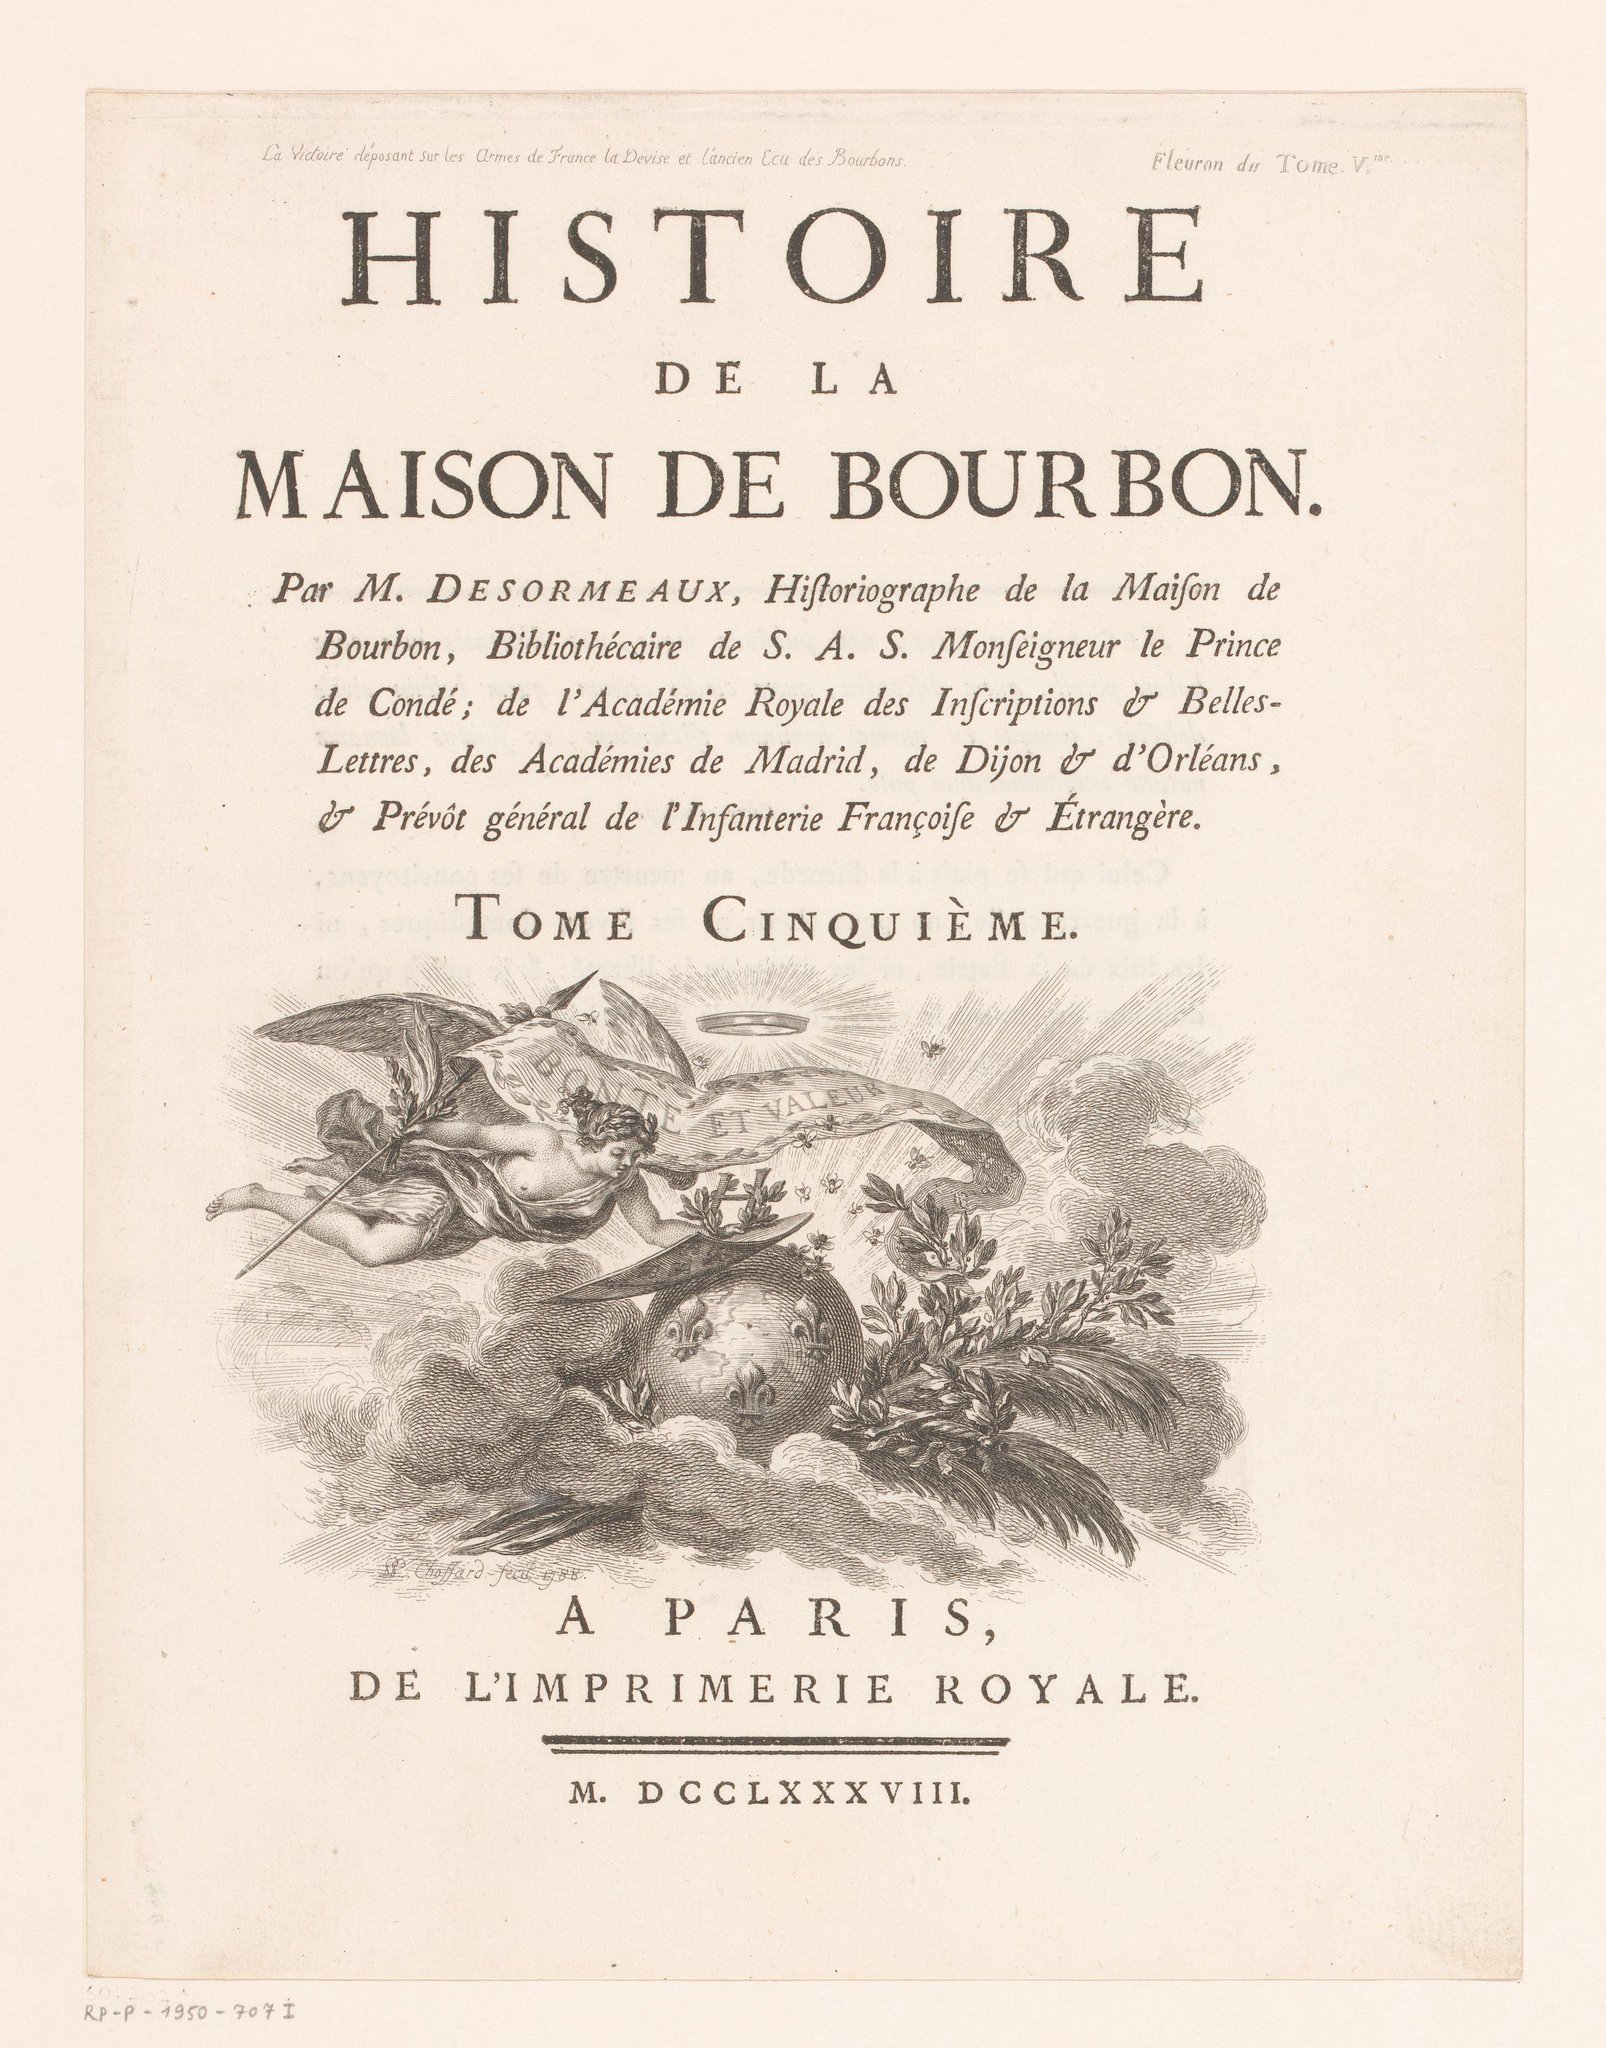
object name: print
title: Allegorische voorstelling met engel en schild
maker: pierre philippe choffard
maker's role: print maker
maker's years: 1730-1809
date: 1788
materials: paper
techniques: engraving, etching, letterpress printing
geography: france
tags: protective weapons: shield, female angels, insects: fly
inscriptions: collector's mark: Lugt 2228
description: Titelpagina voor: Désormeaux, Joseph-Louis-Ripault. Histoire de la maison de Bourbon. Parijs: L'imprimerie royale, 1788, dl. 5.